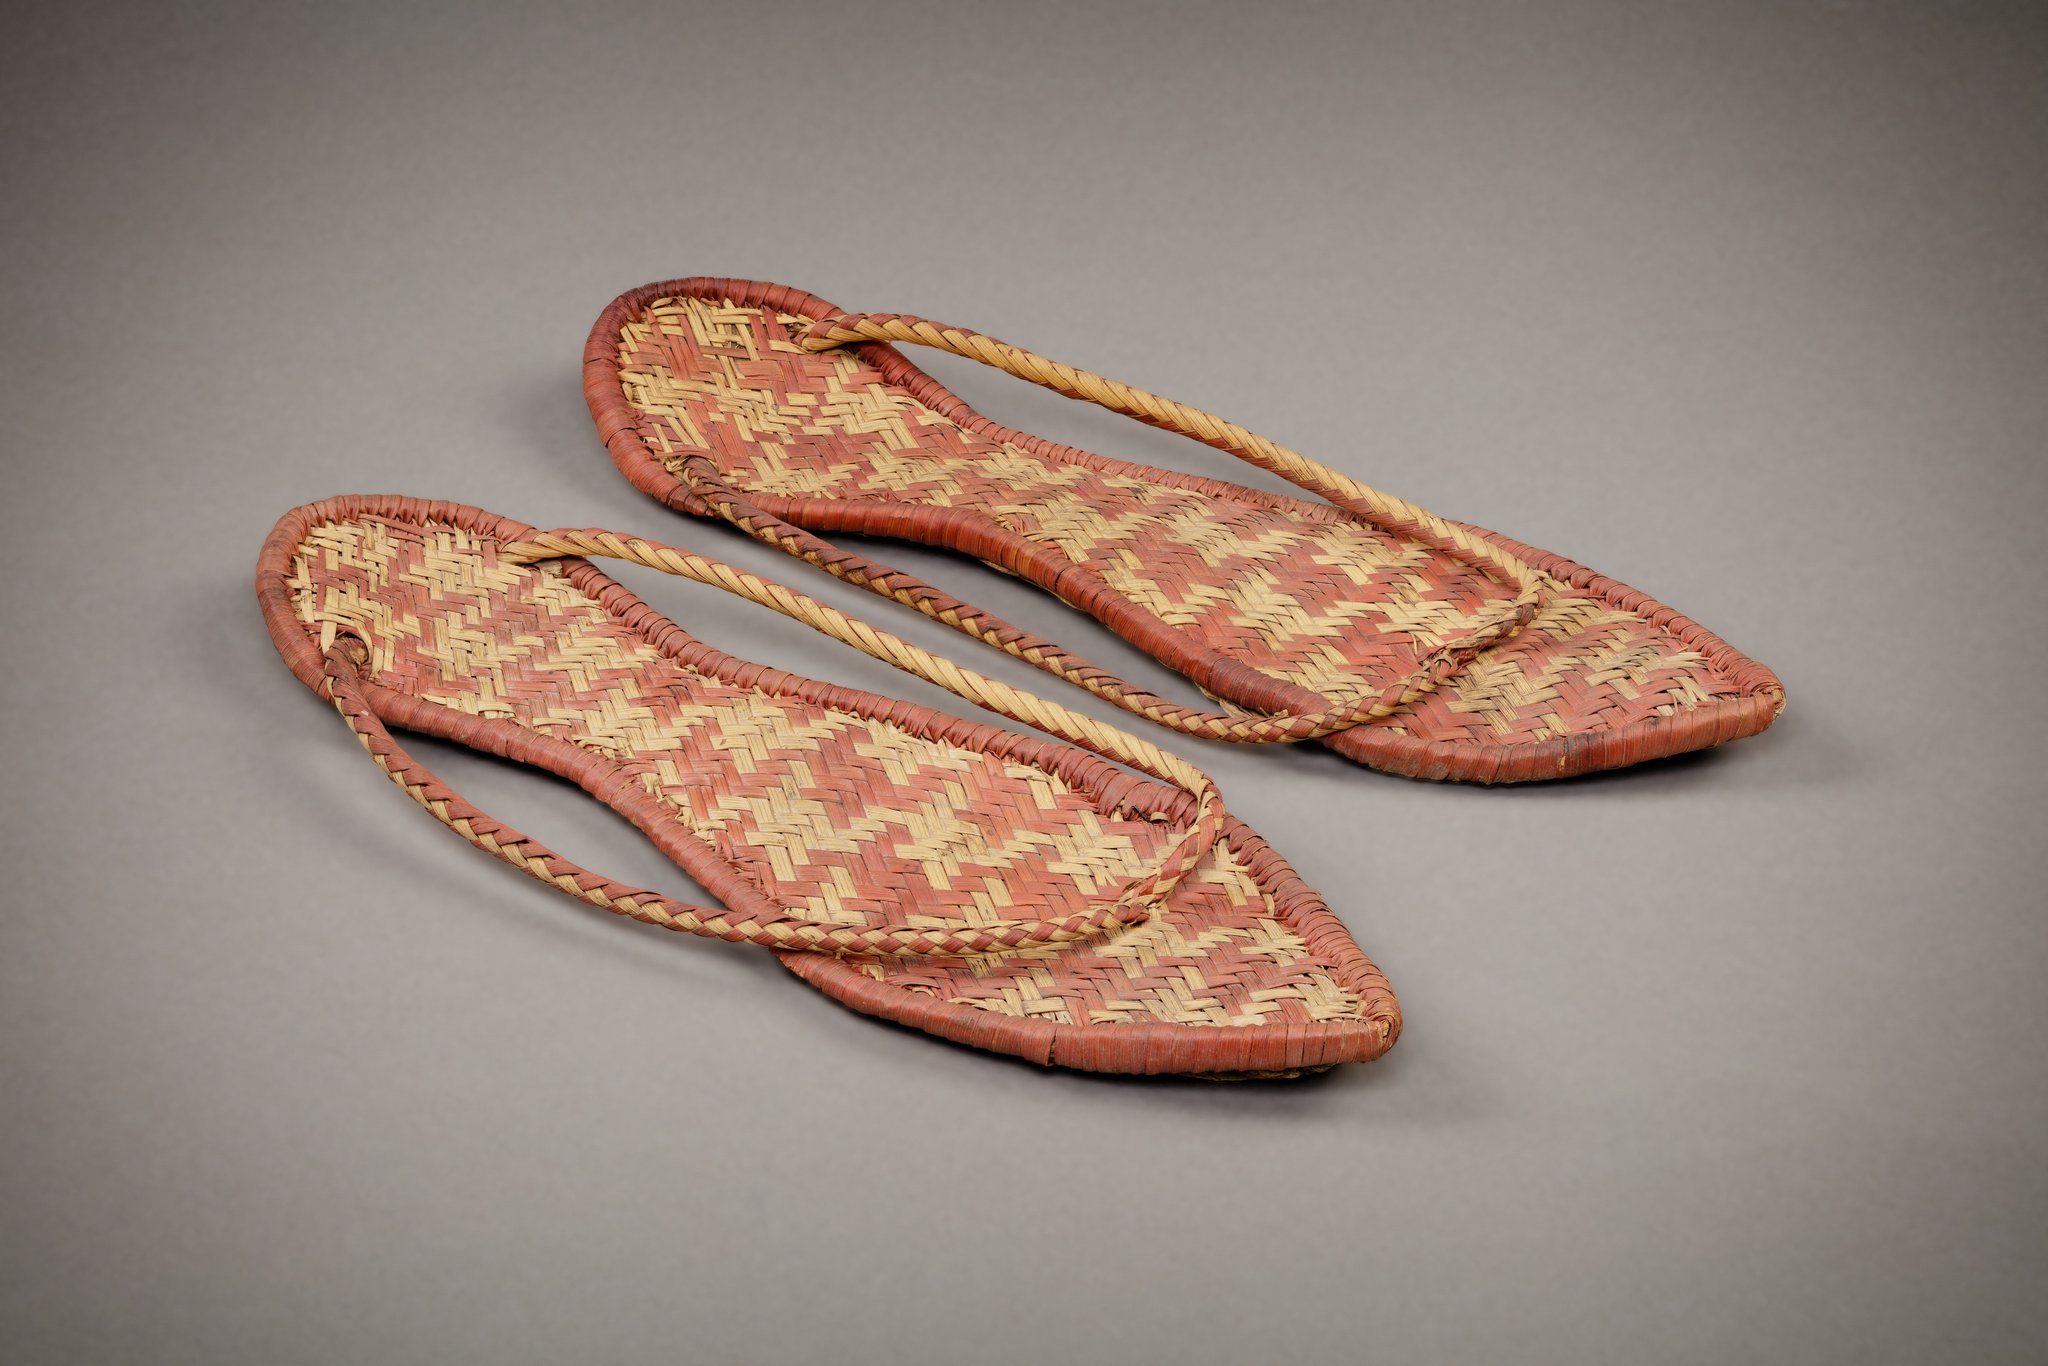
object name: sandal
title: Funerary Sandals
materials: dye, leaf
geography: egypt